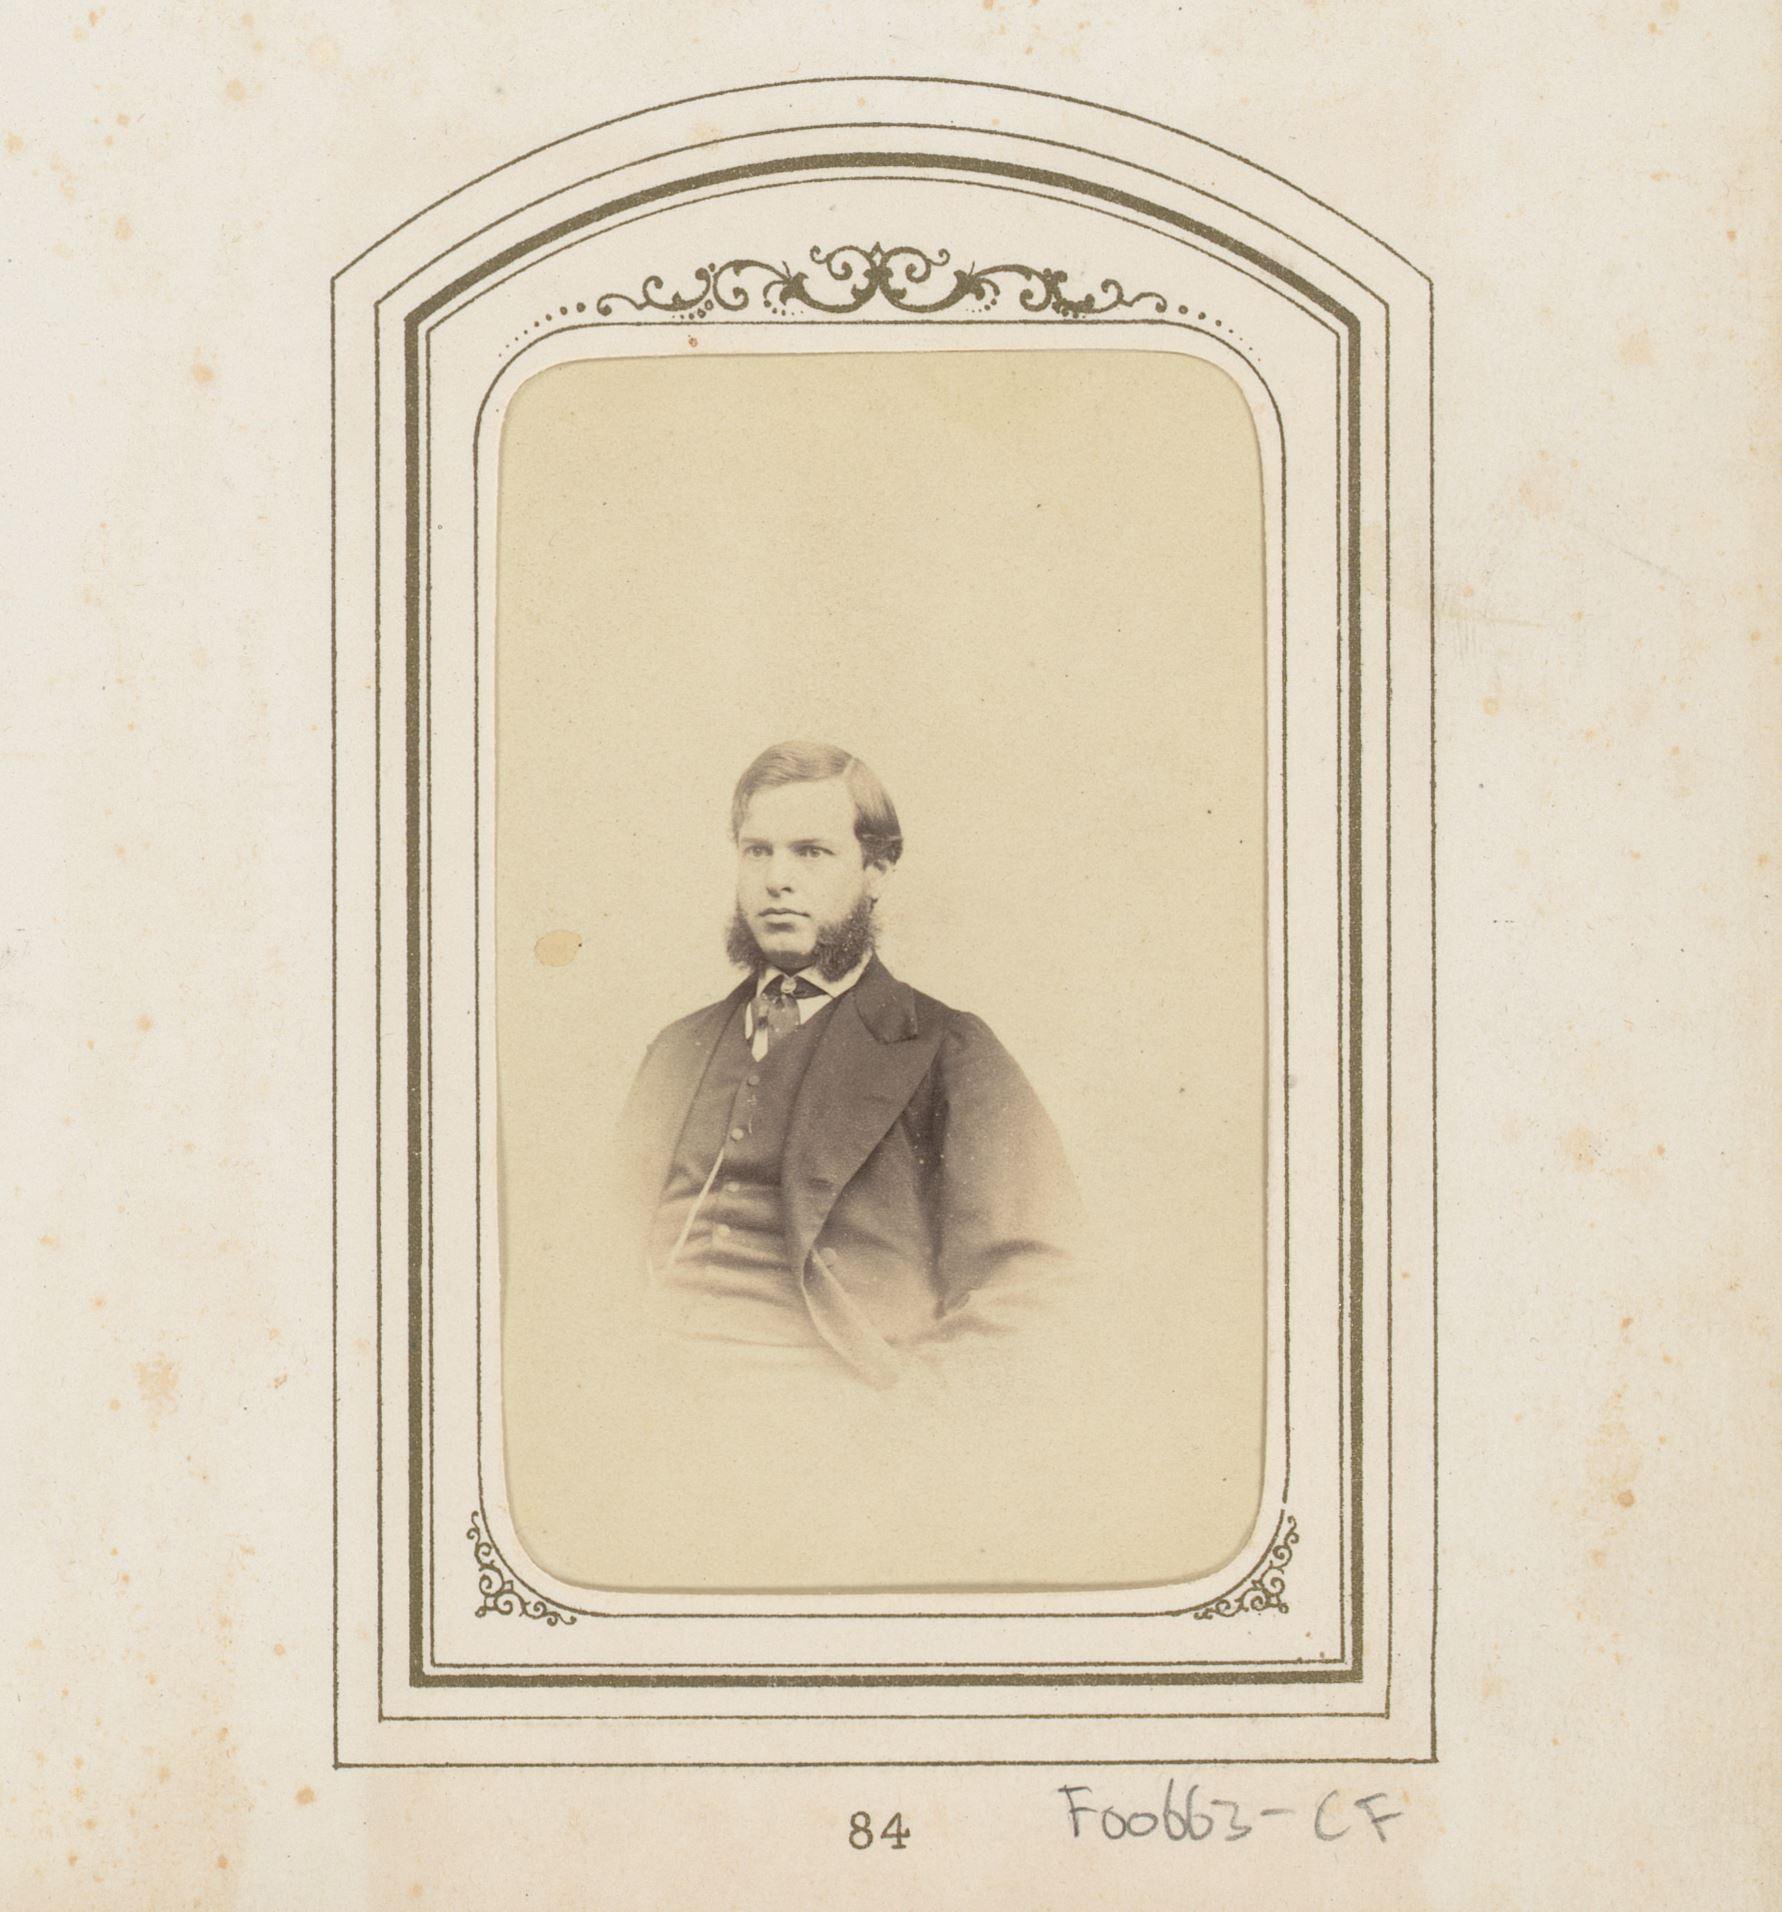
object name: photograph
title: Portret van een man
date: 1861-1863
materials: cardboard, photographic support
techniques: albumen print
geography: london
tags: historical persons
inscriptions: inscription: ‘McLean, Melhuish & Haes/ 26, Haymarket/ Photographers/ No.[6027]’, number: ‘84’